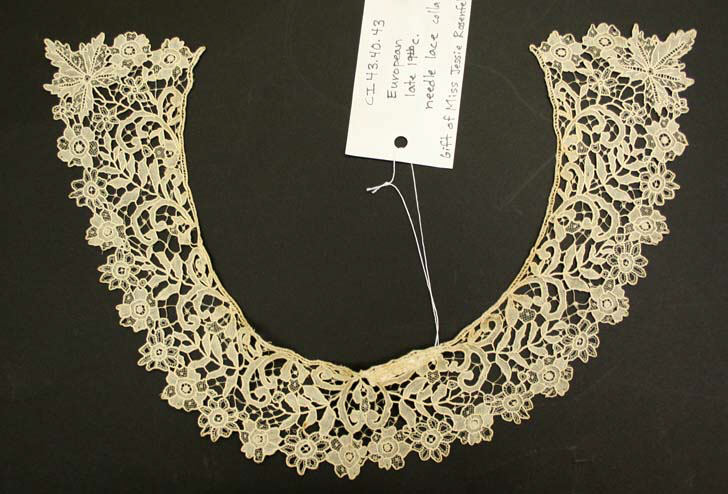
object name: collar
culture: american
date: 1700-1943